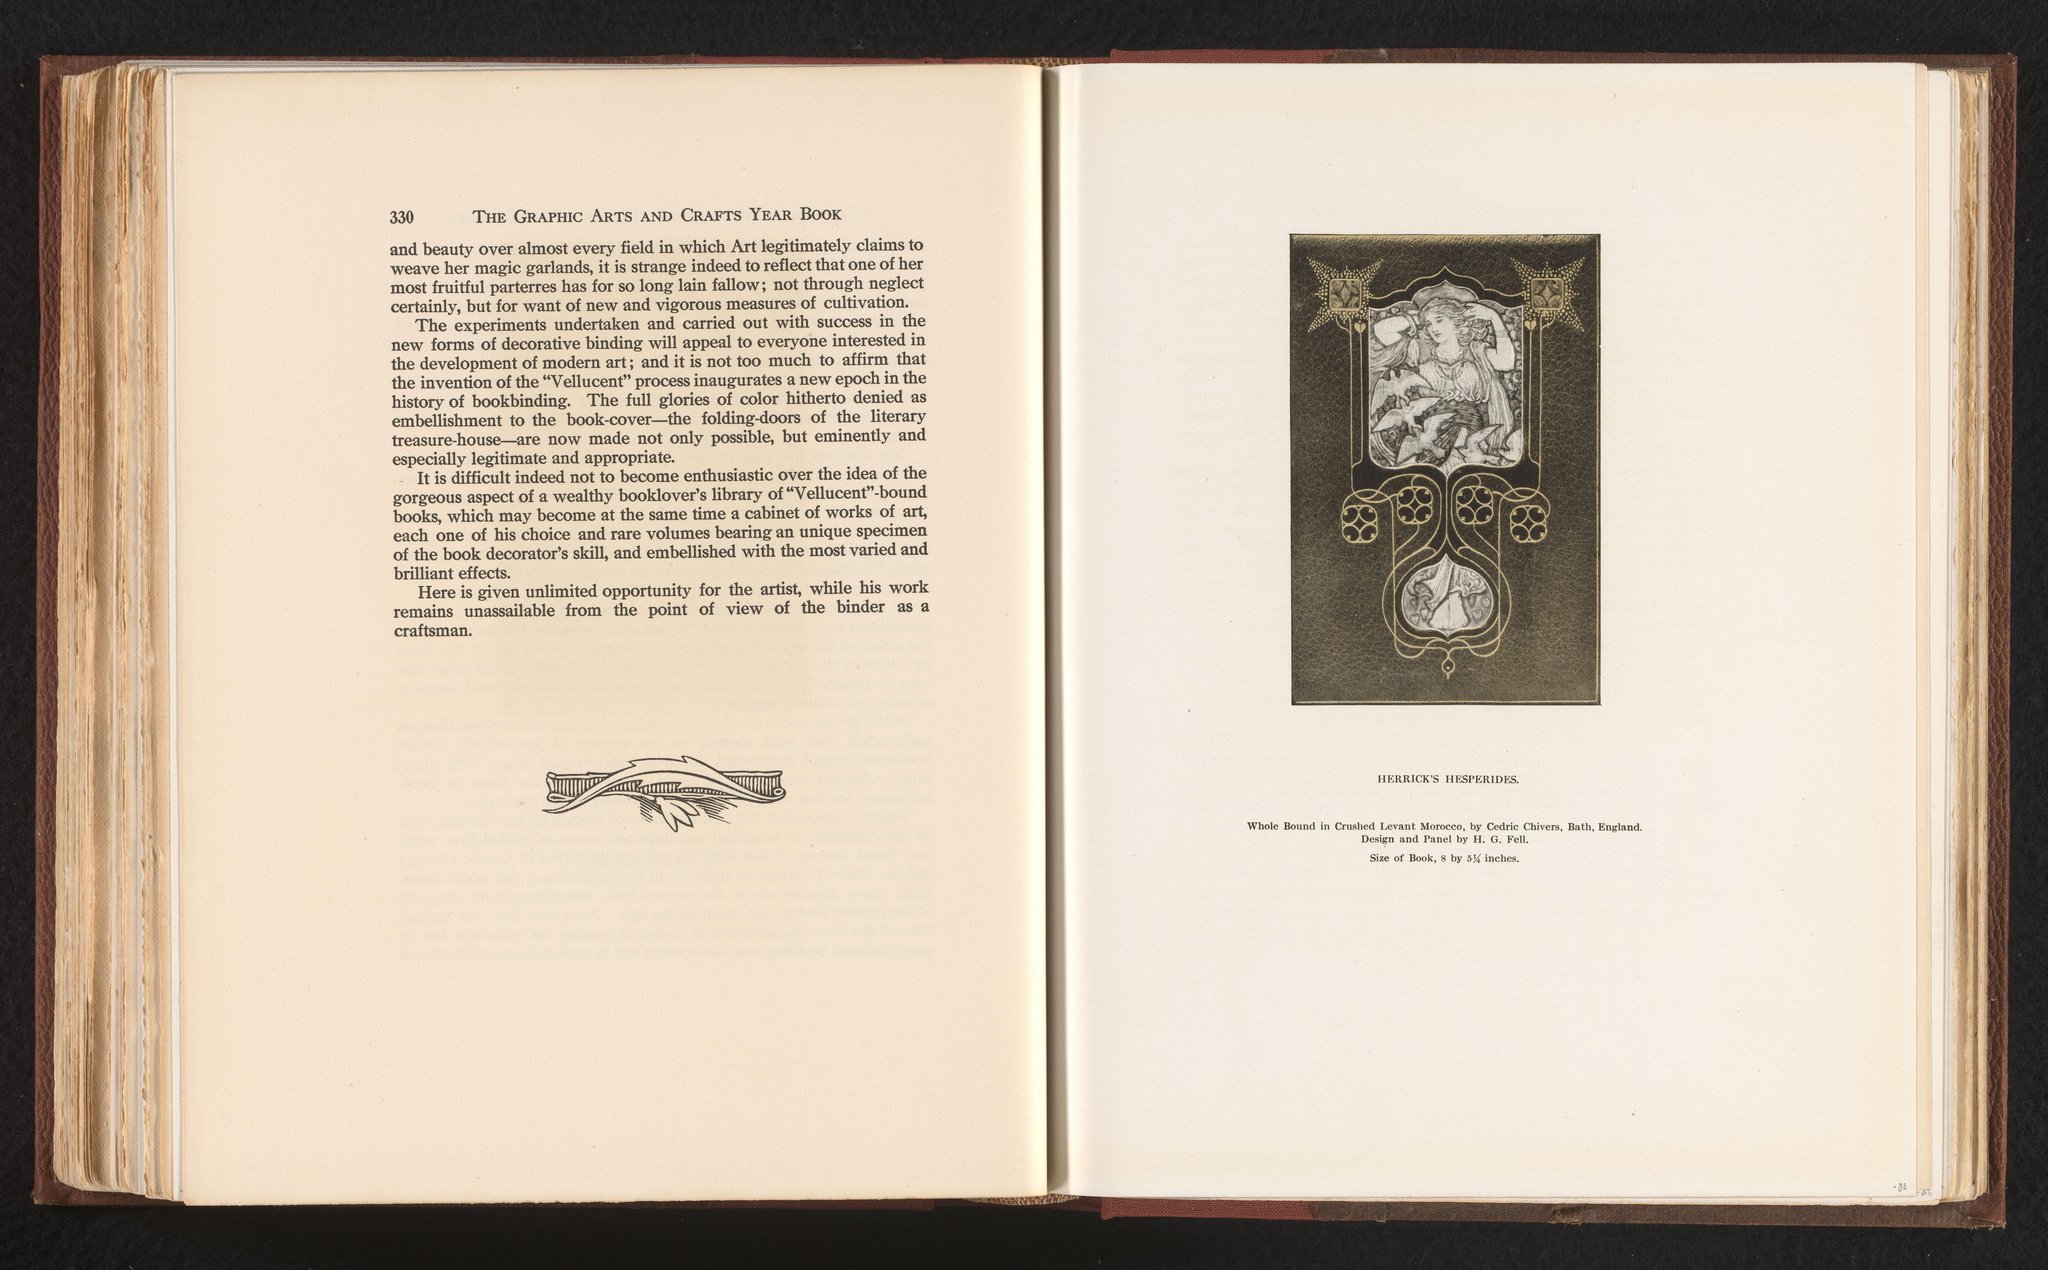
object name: page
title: Herrick's Hesperides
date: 1904-1909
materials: paper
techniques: color autotype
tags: book-cover, binding